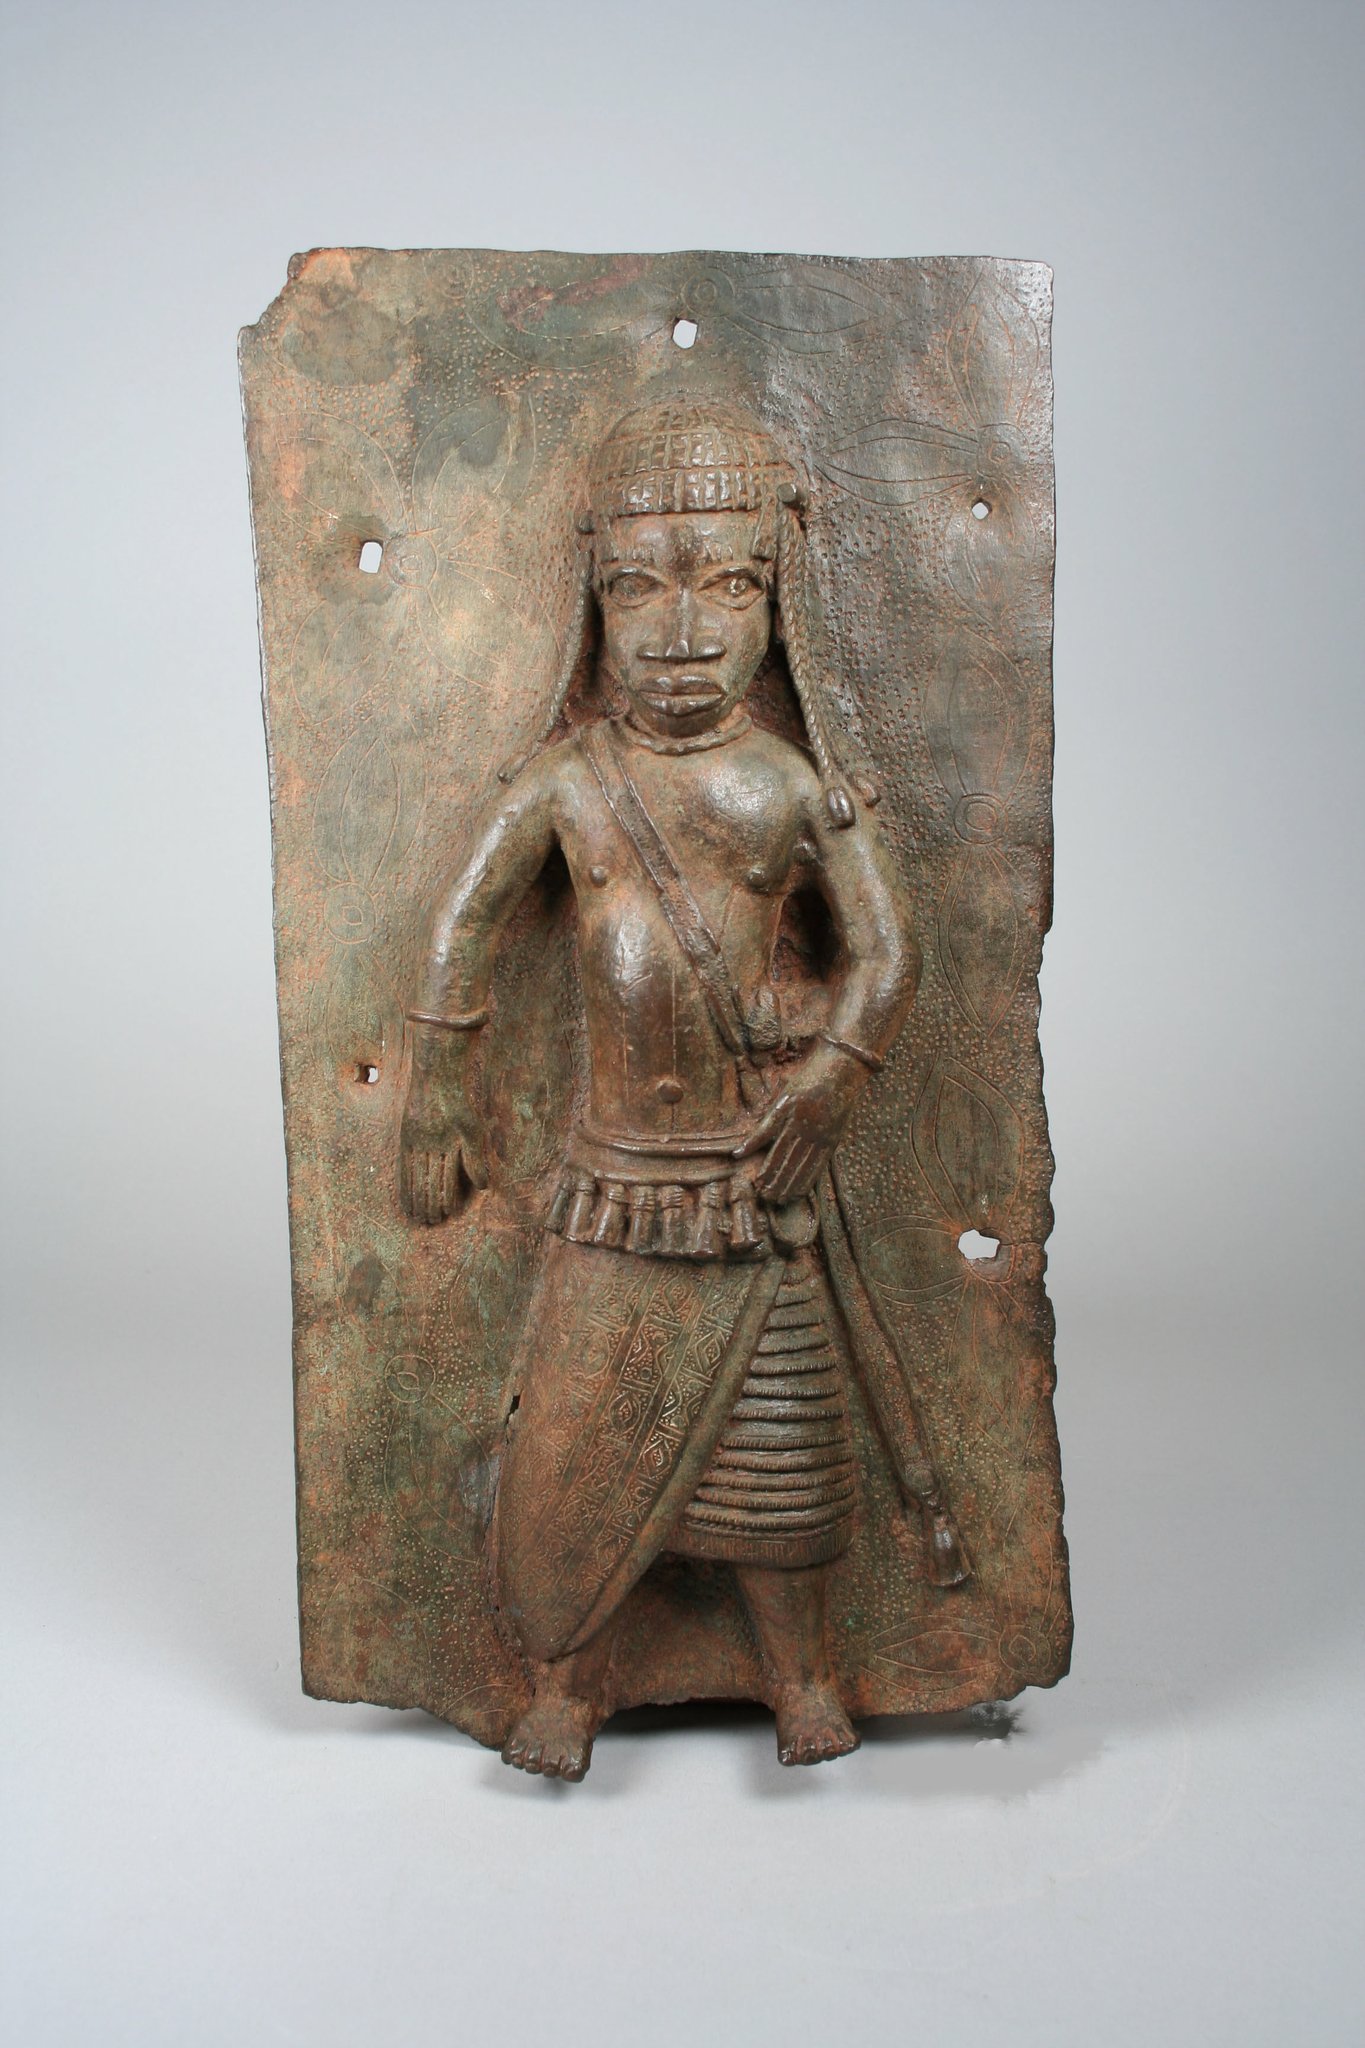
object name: plaque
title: Plaque: Court Official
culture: edo period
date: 1501-1700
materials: brass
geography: nigeria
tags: men